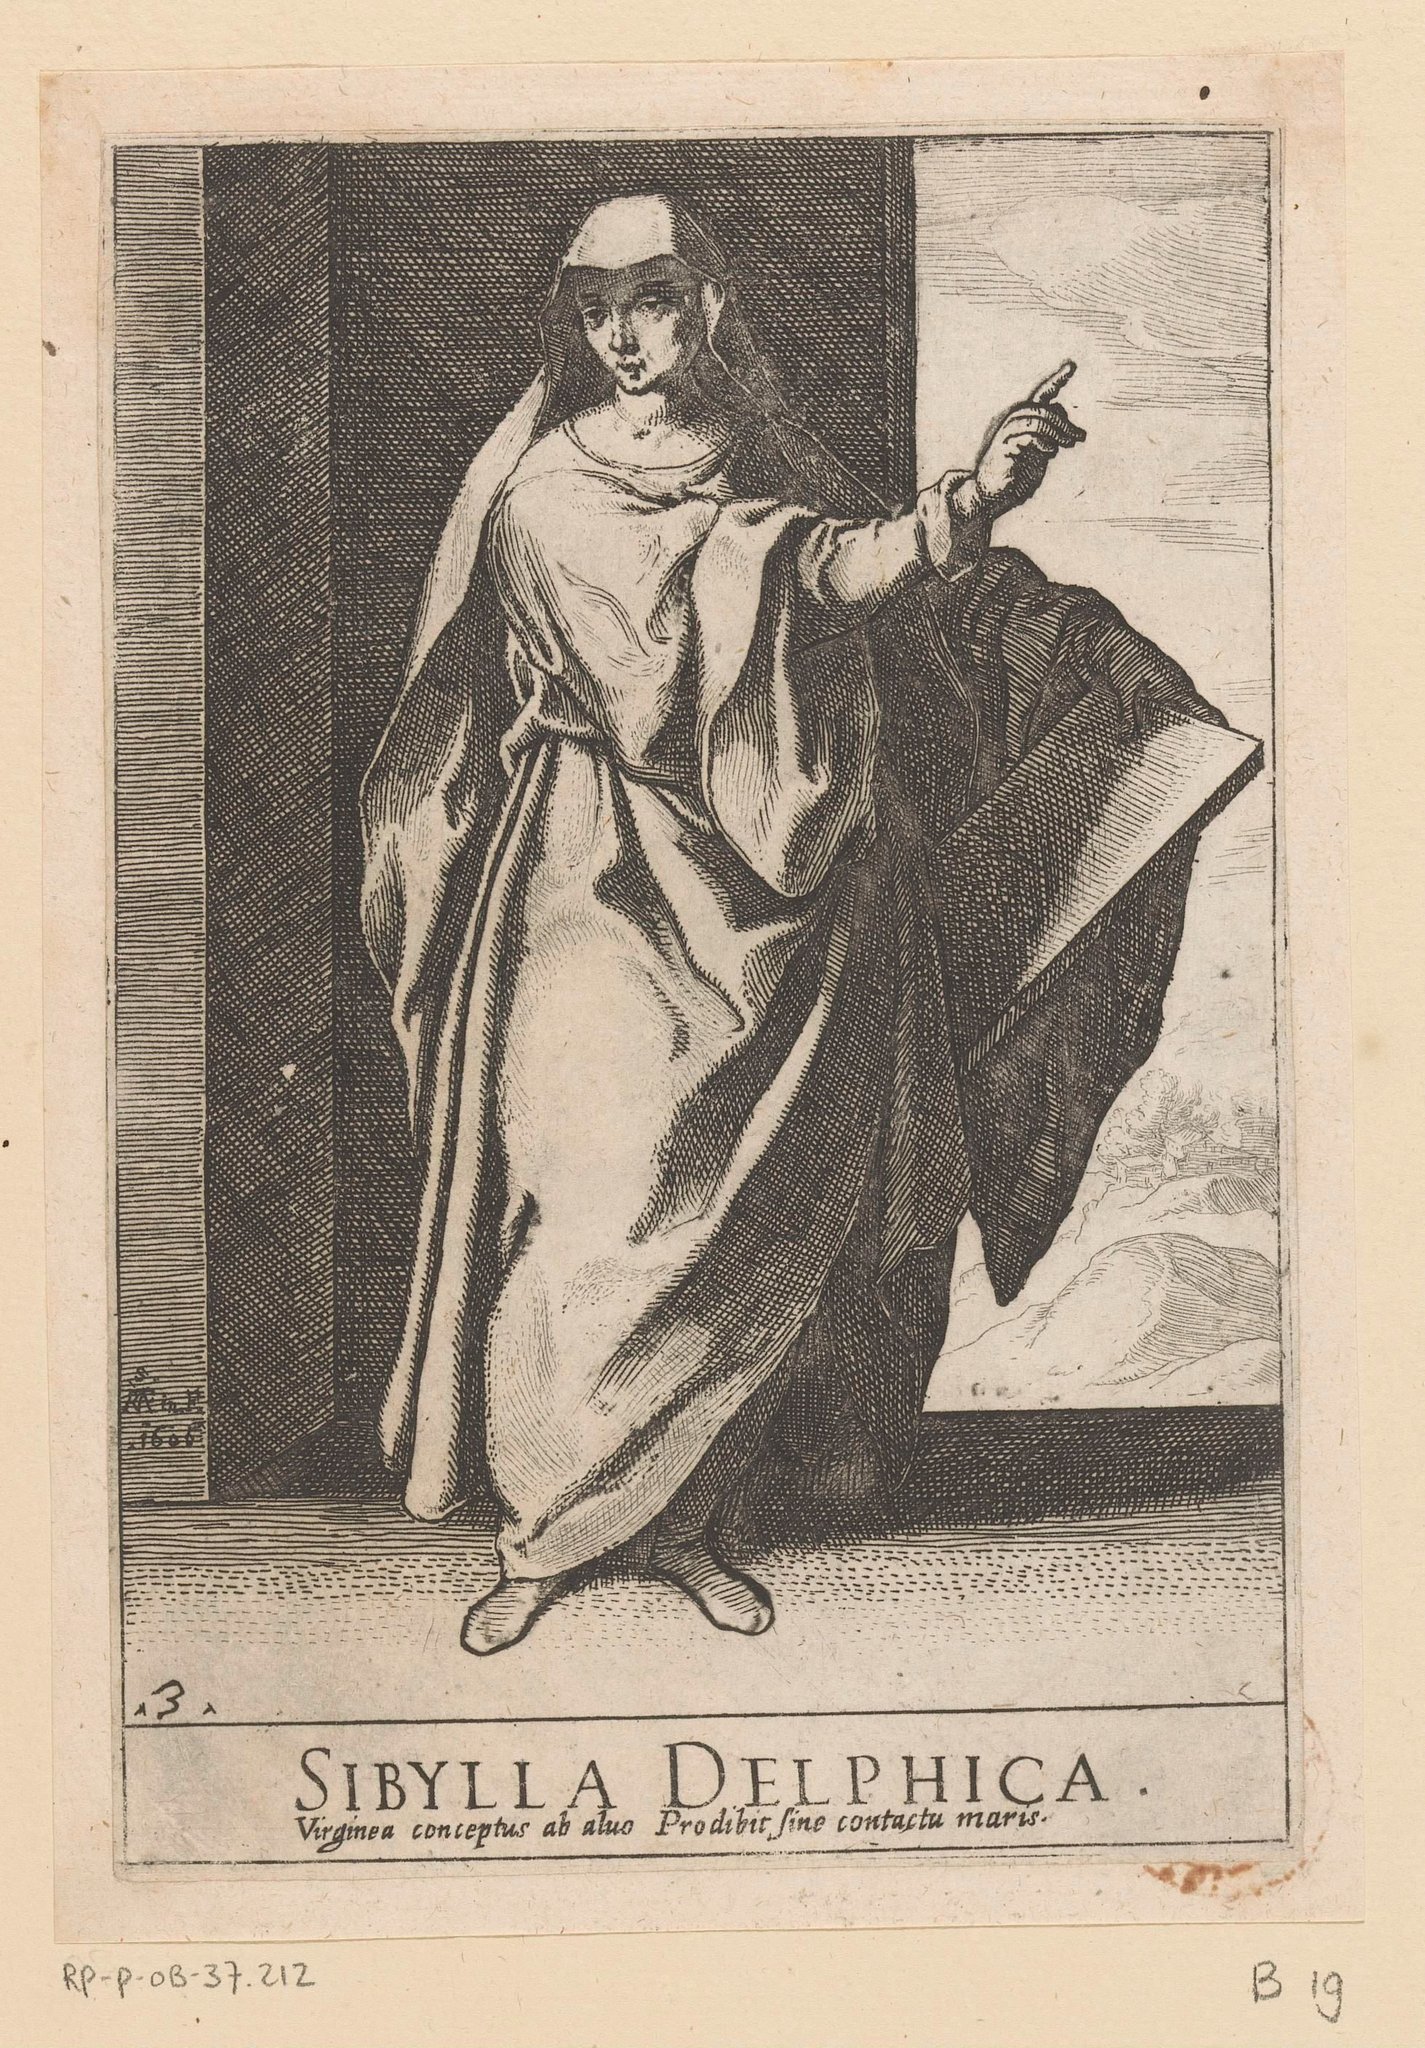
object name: print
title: Sibylla Delphica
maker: raffaello schiaminossi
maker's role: painter, print maker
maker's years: 1572-1622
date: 1606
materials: paper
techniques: etching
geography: italy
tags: writing tablets, sibyls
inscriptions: collector's mark: Lugt 240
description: Deze prent maakt deel uit van een serie bestaande uit een titelprent en tien prenten met voorstellingen van Sibillen. De serie is drie keer uitgegeven: eenmaal in 1606 en tweemaal in 1609 door verschillende uitgevers. Om deze reden worden de prenten uit deze serie hier 1606-1609 gedateerd, behalve indien de individuele prent zelf gedateerd is.